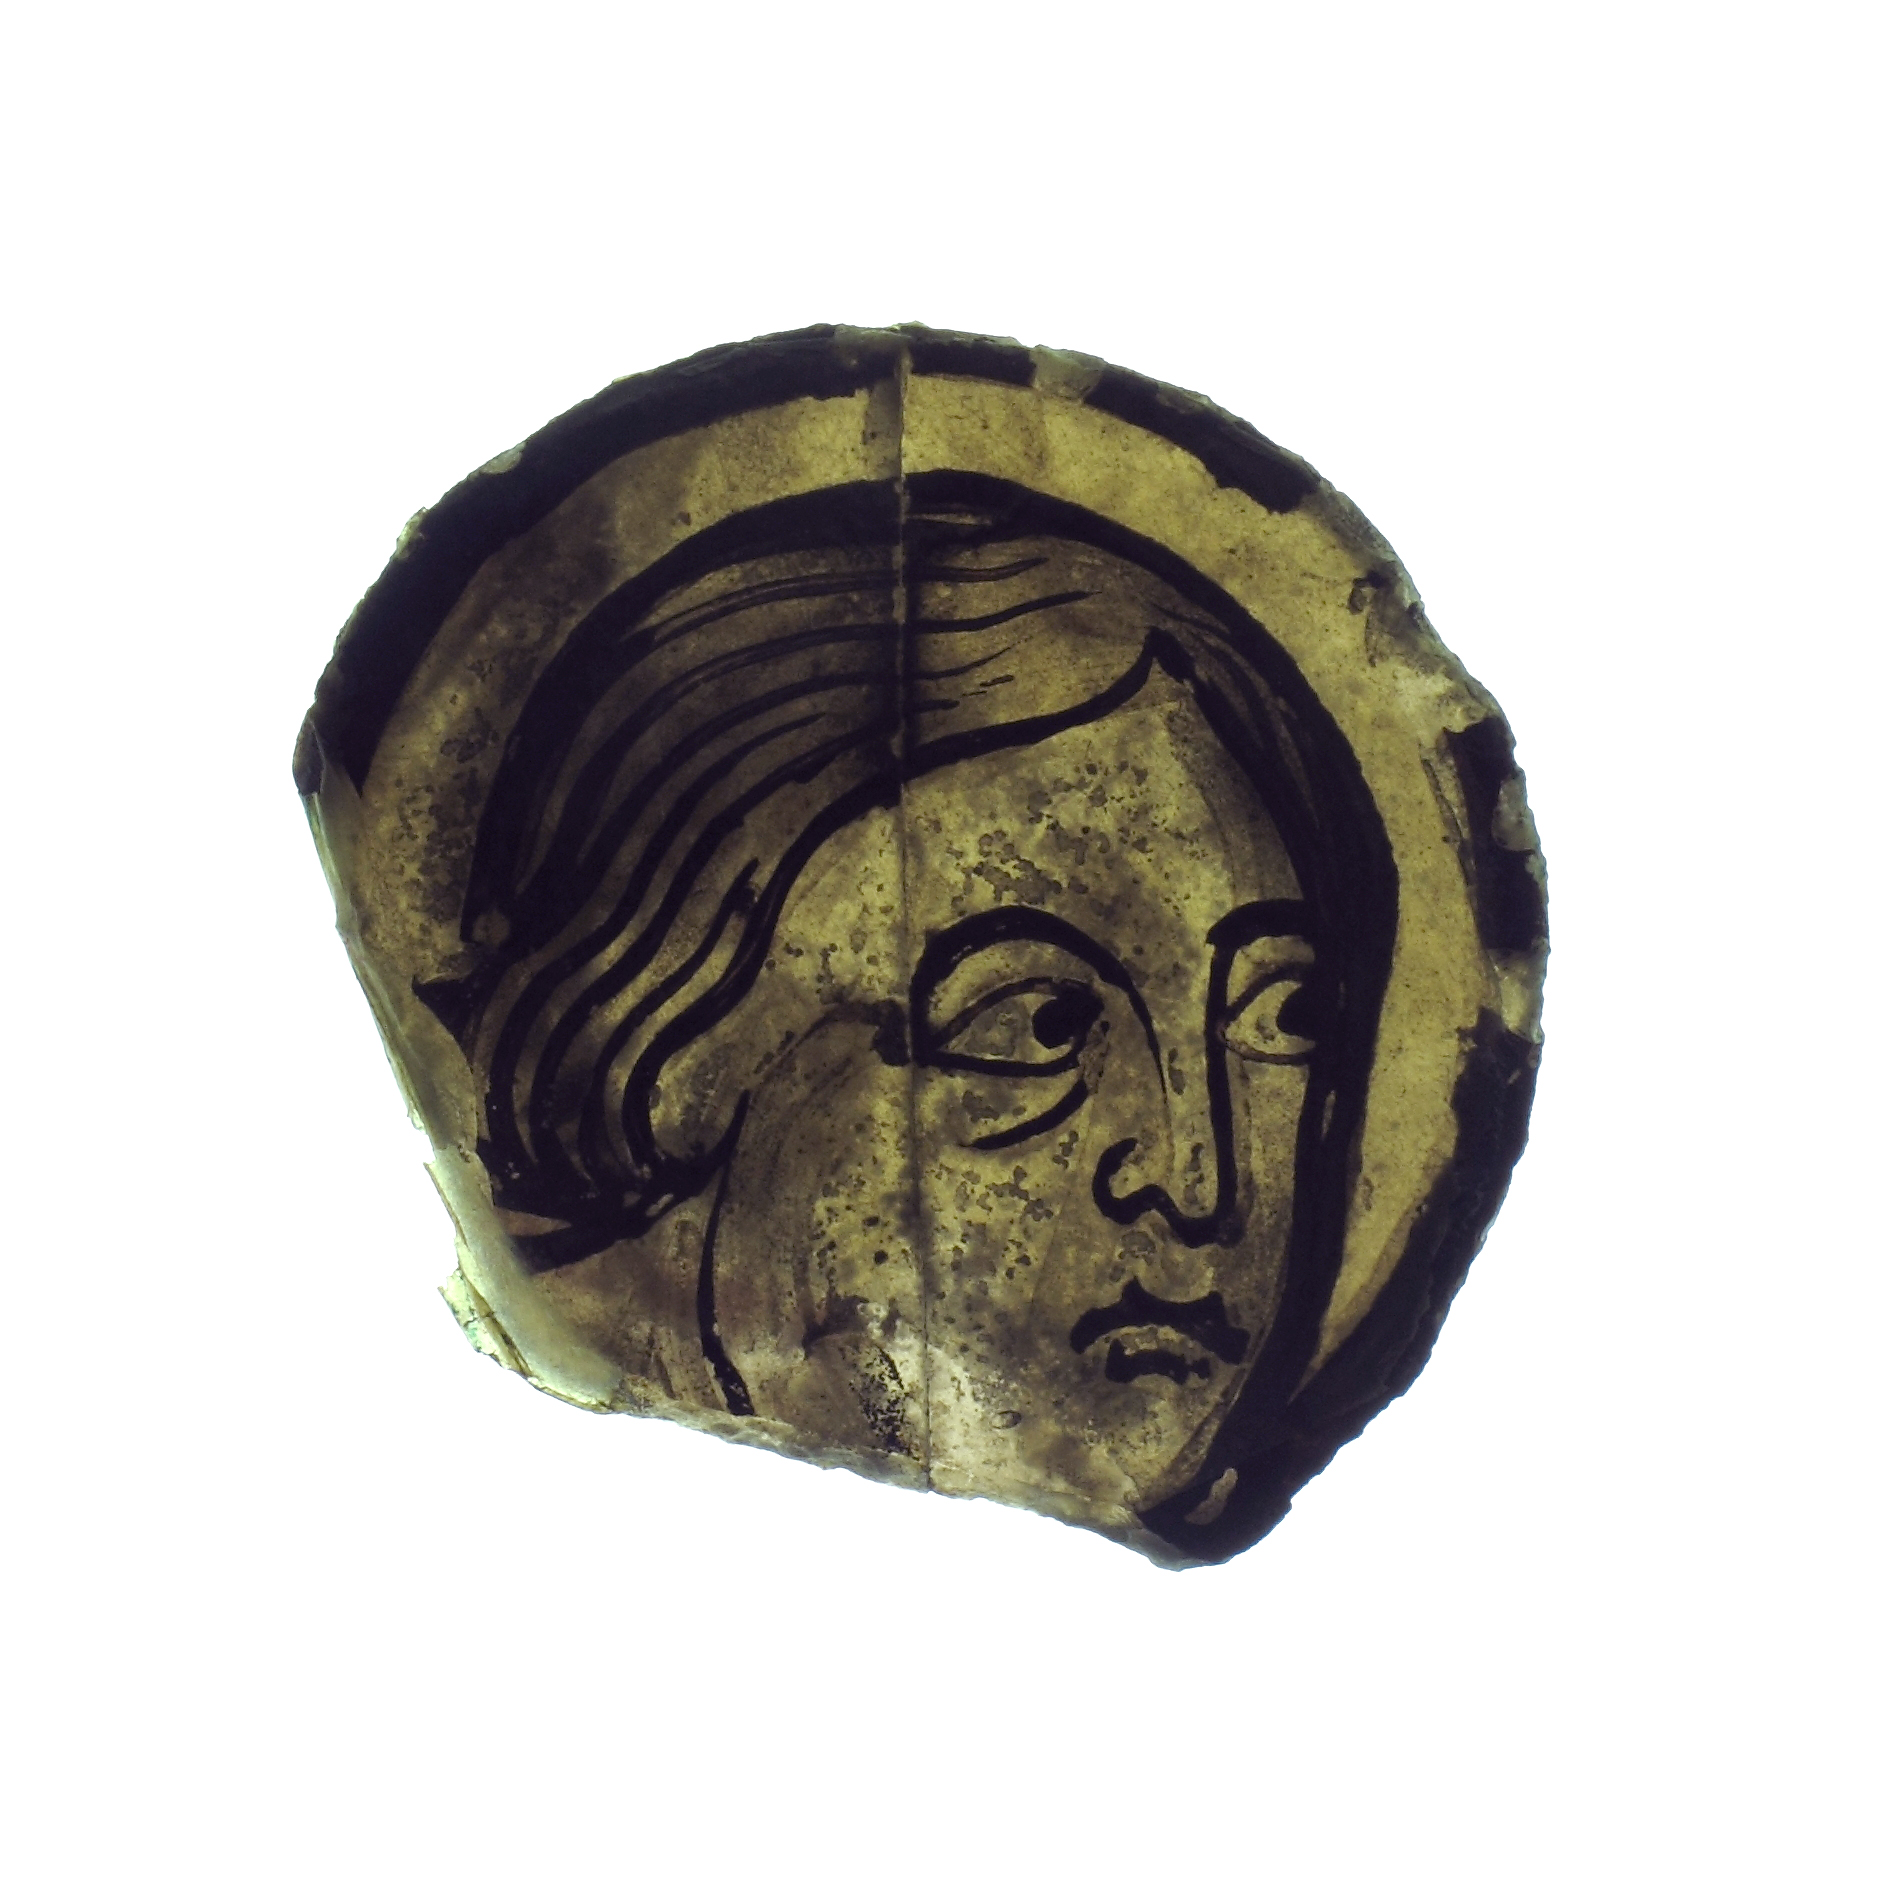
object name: fragment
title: Glass Fragment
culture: french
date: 1101-1400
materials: glass, metal, paint